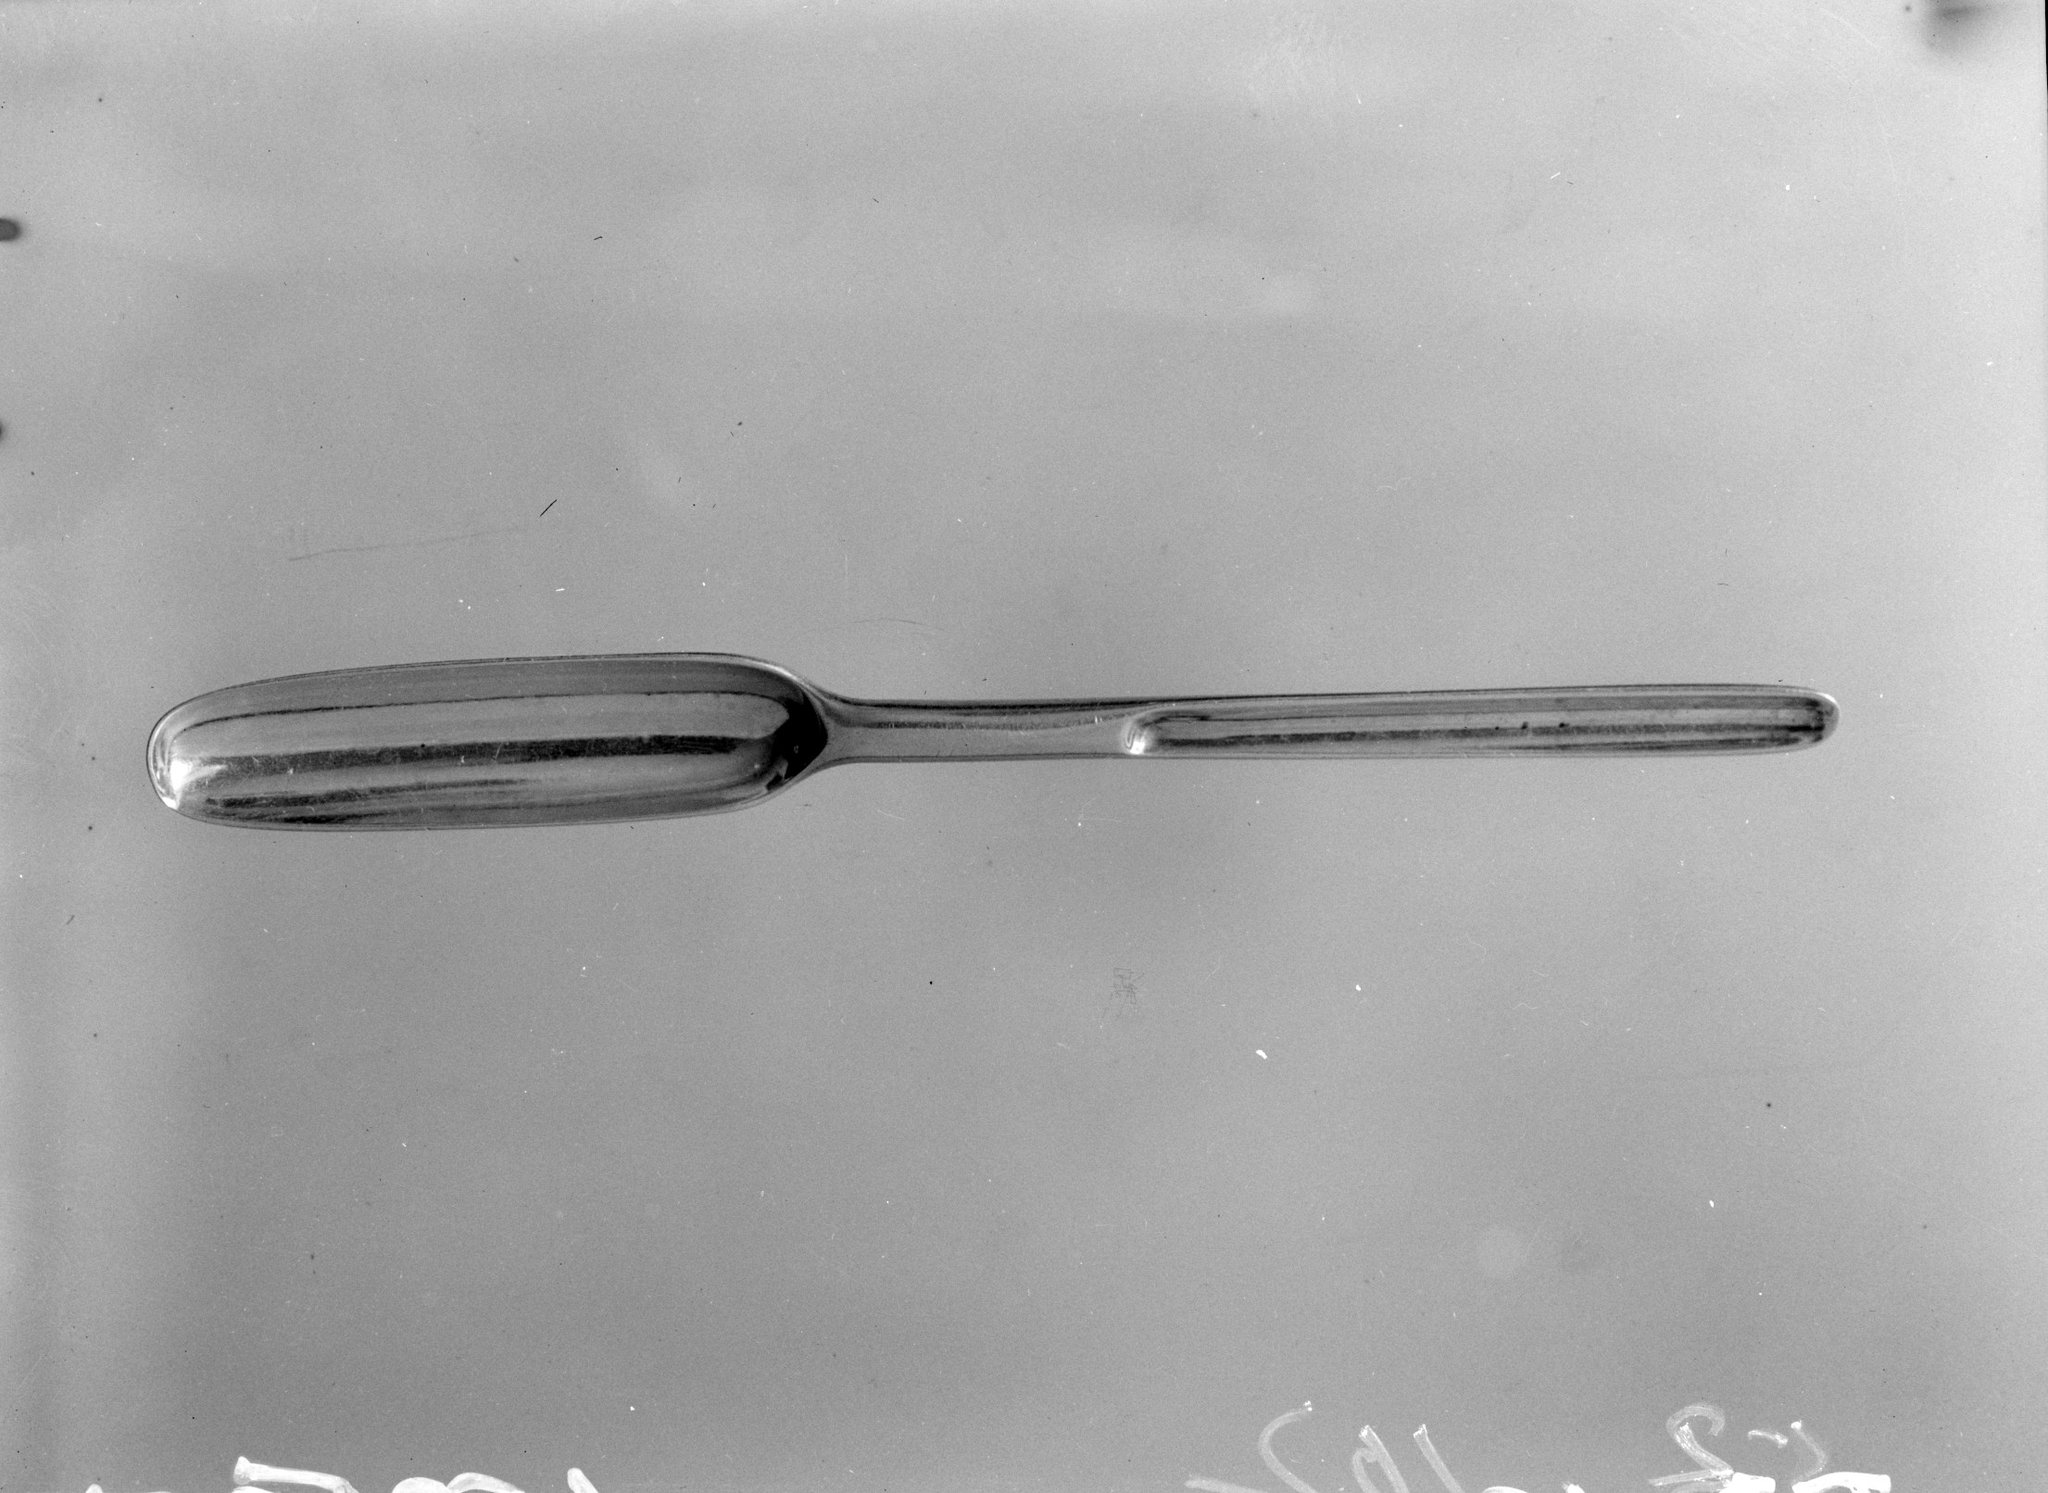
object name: spoon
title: Marrow Spoon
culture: british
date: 1700-1800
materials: silver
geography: england